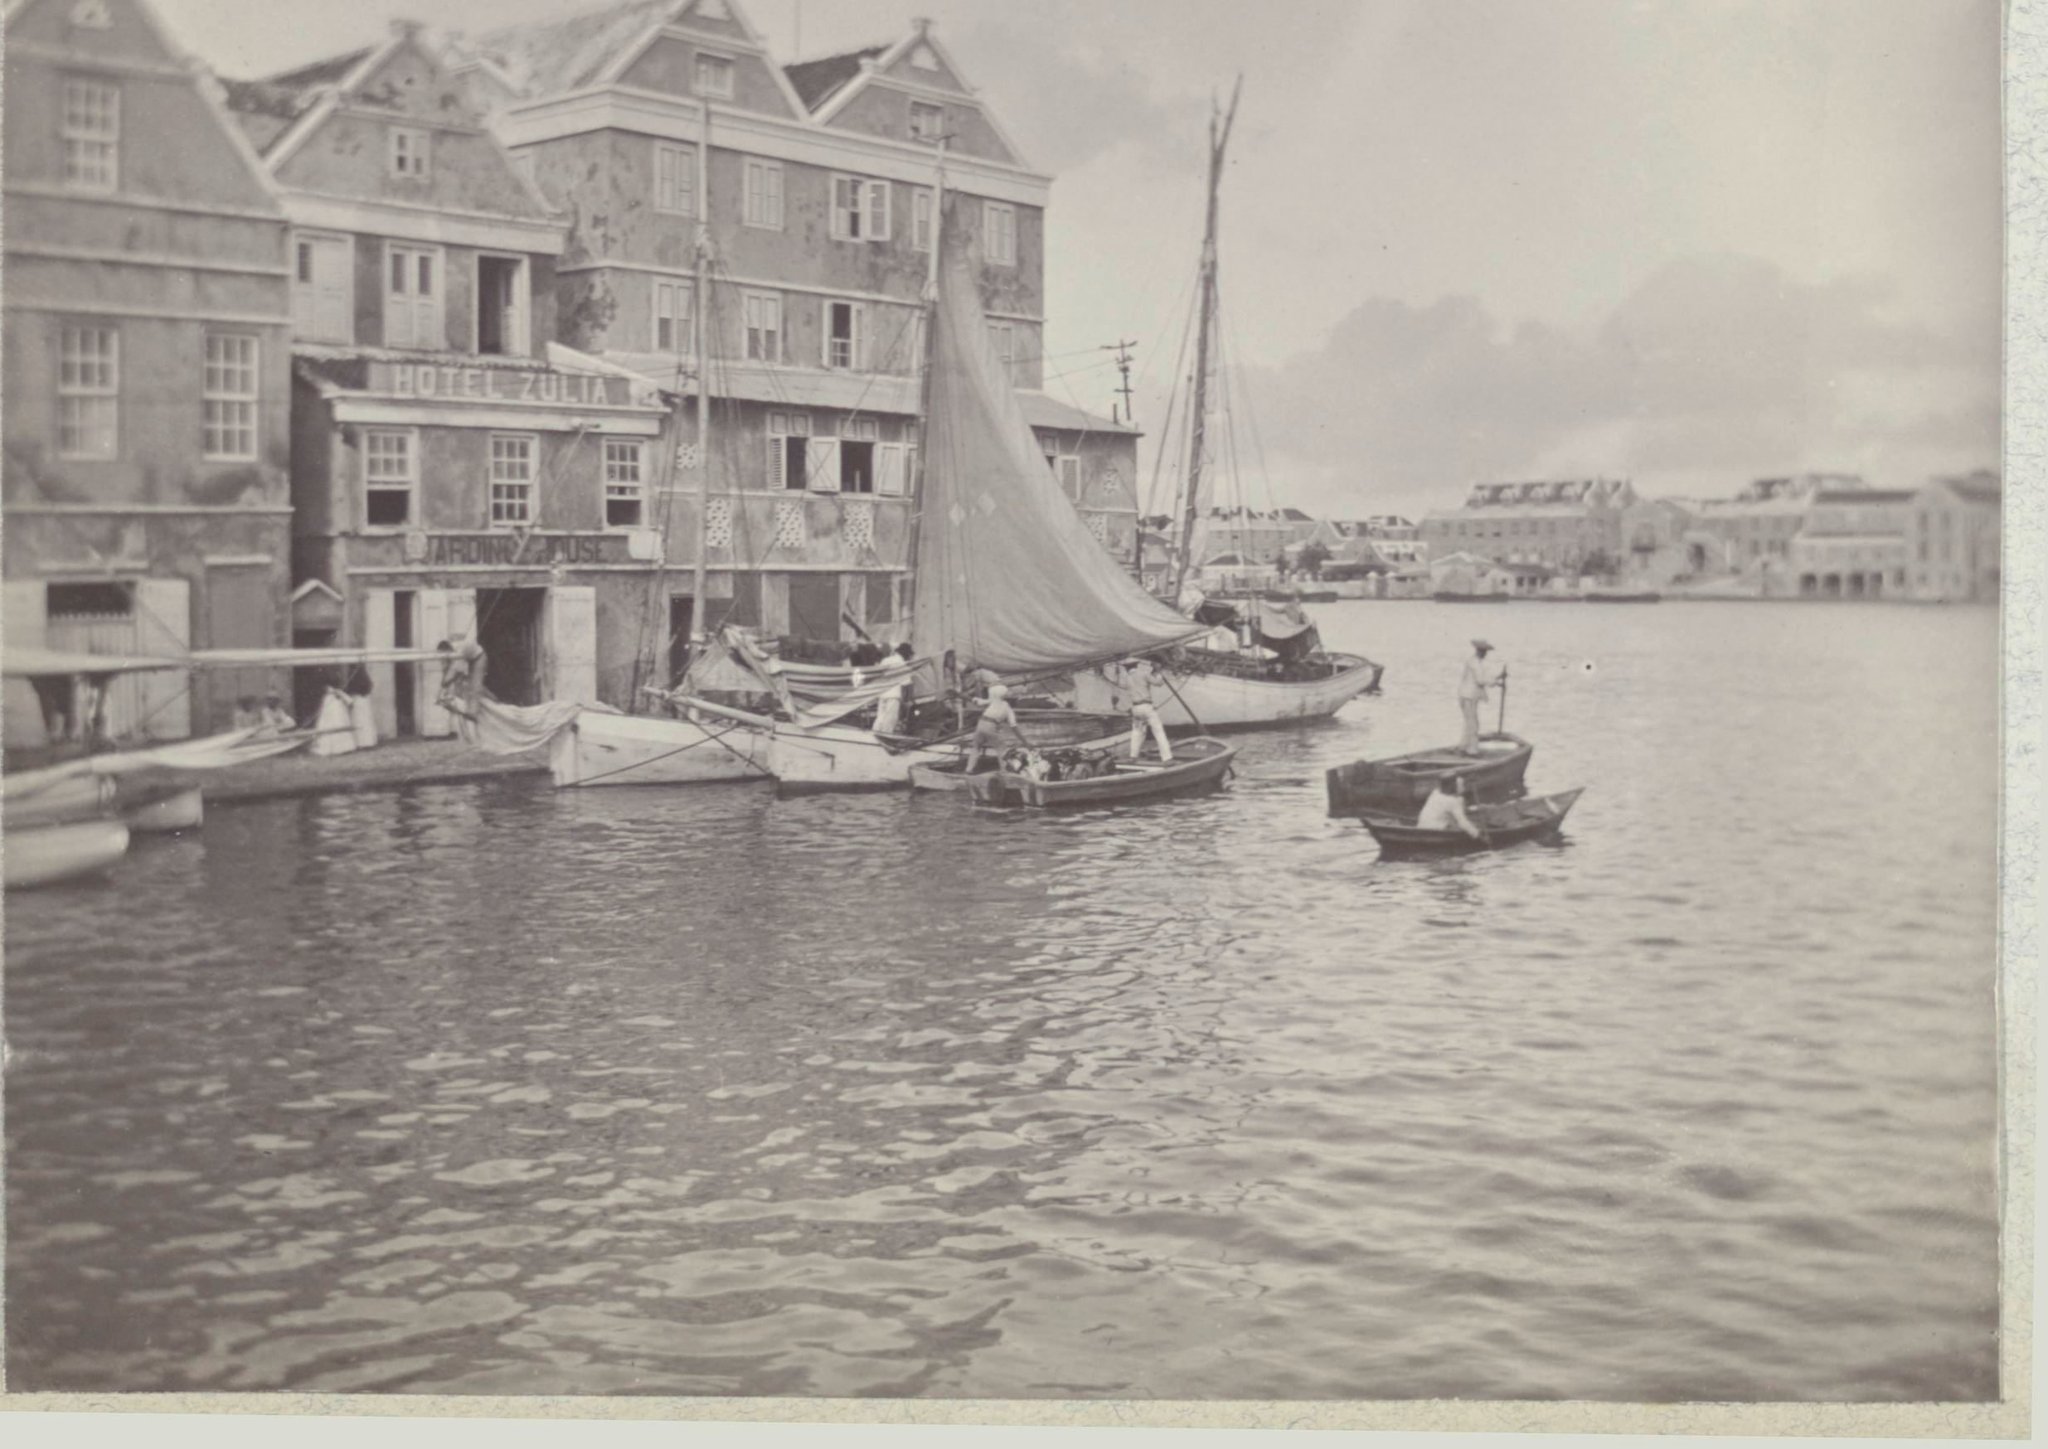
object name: photograph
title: Haven van Willemstad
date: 1902-1911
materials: photographic support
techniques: photography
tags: harbour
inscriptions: inscription: ‘Curaçao Febr. 1911’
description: Huizen aan het water in de haven van Willemstad op Curaçao, februari 1911. Onderdeel van het fotoalbum van de familie Boom-Gonggrijp in Suriname en Curaçao.